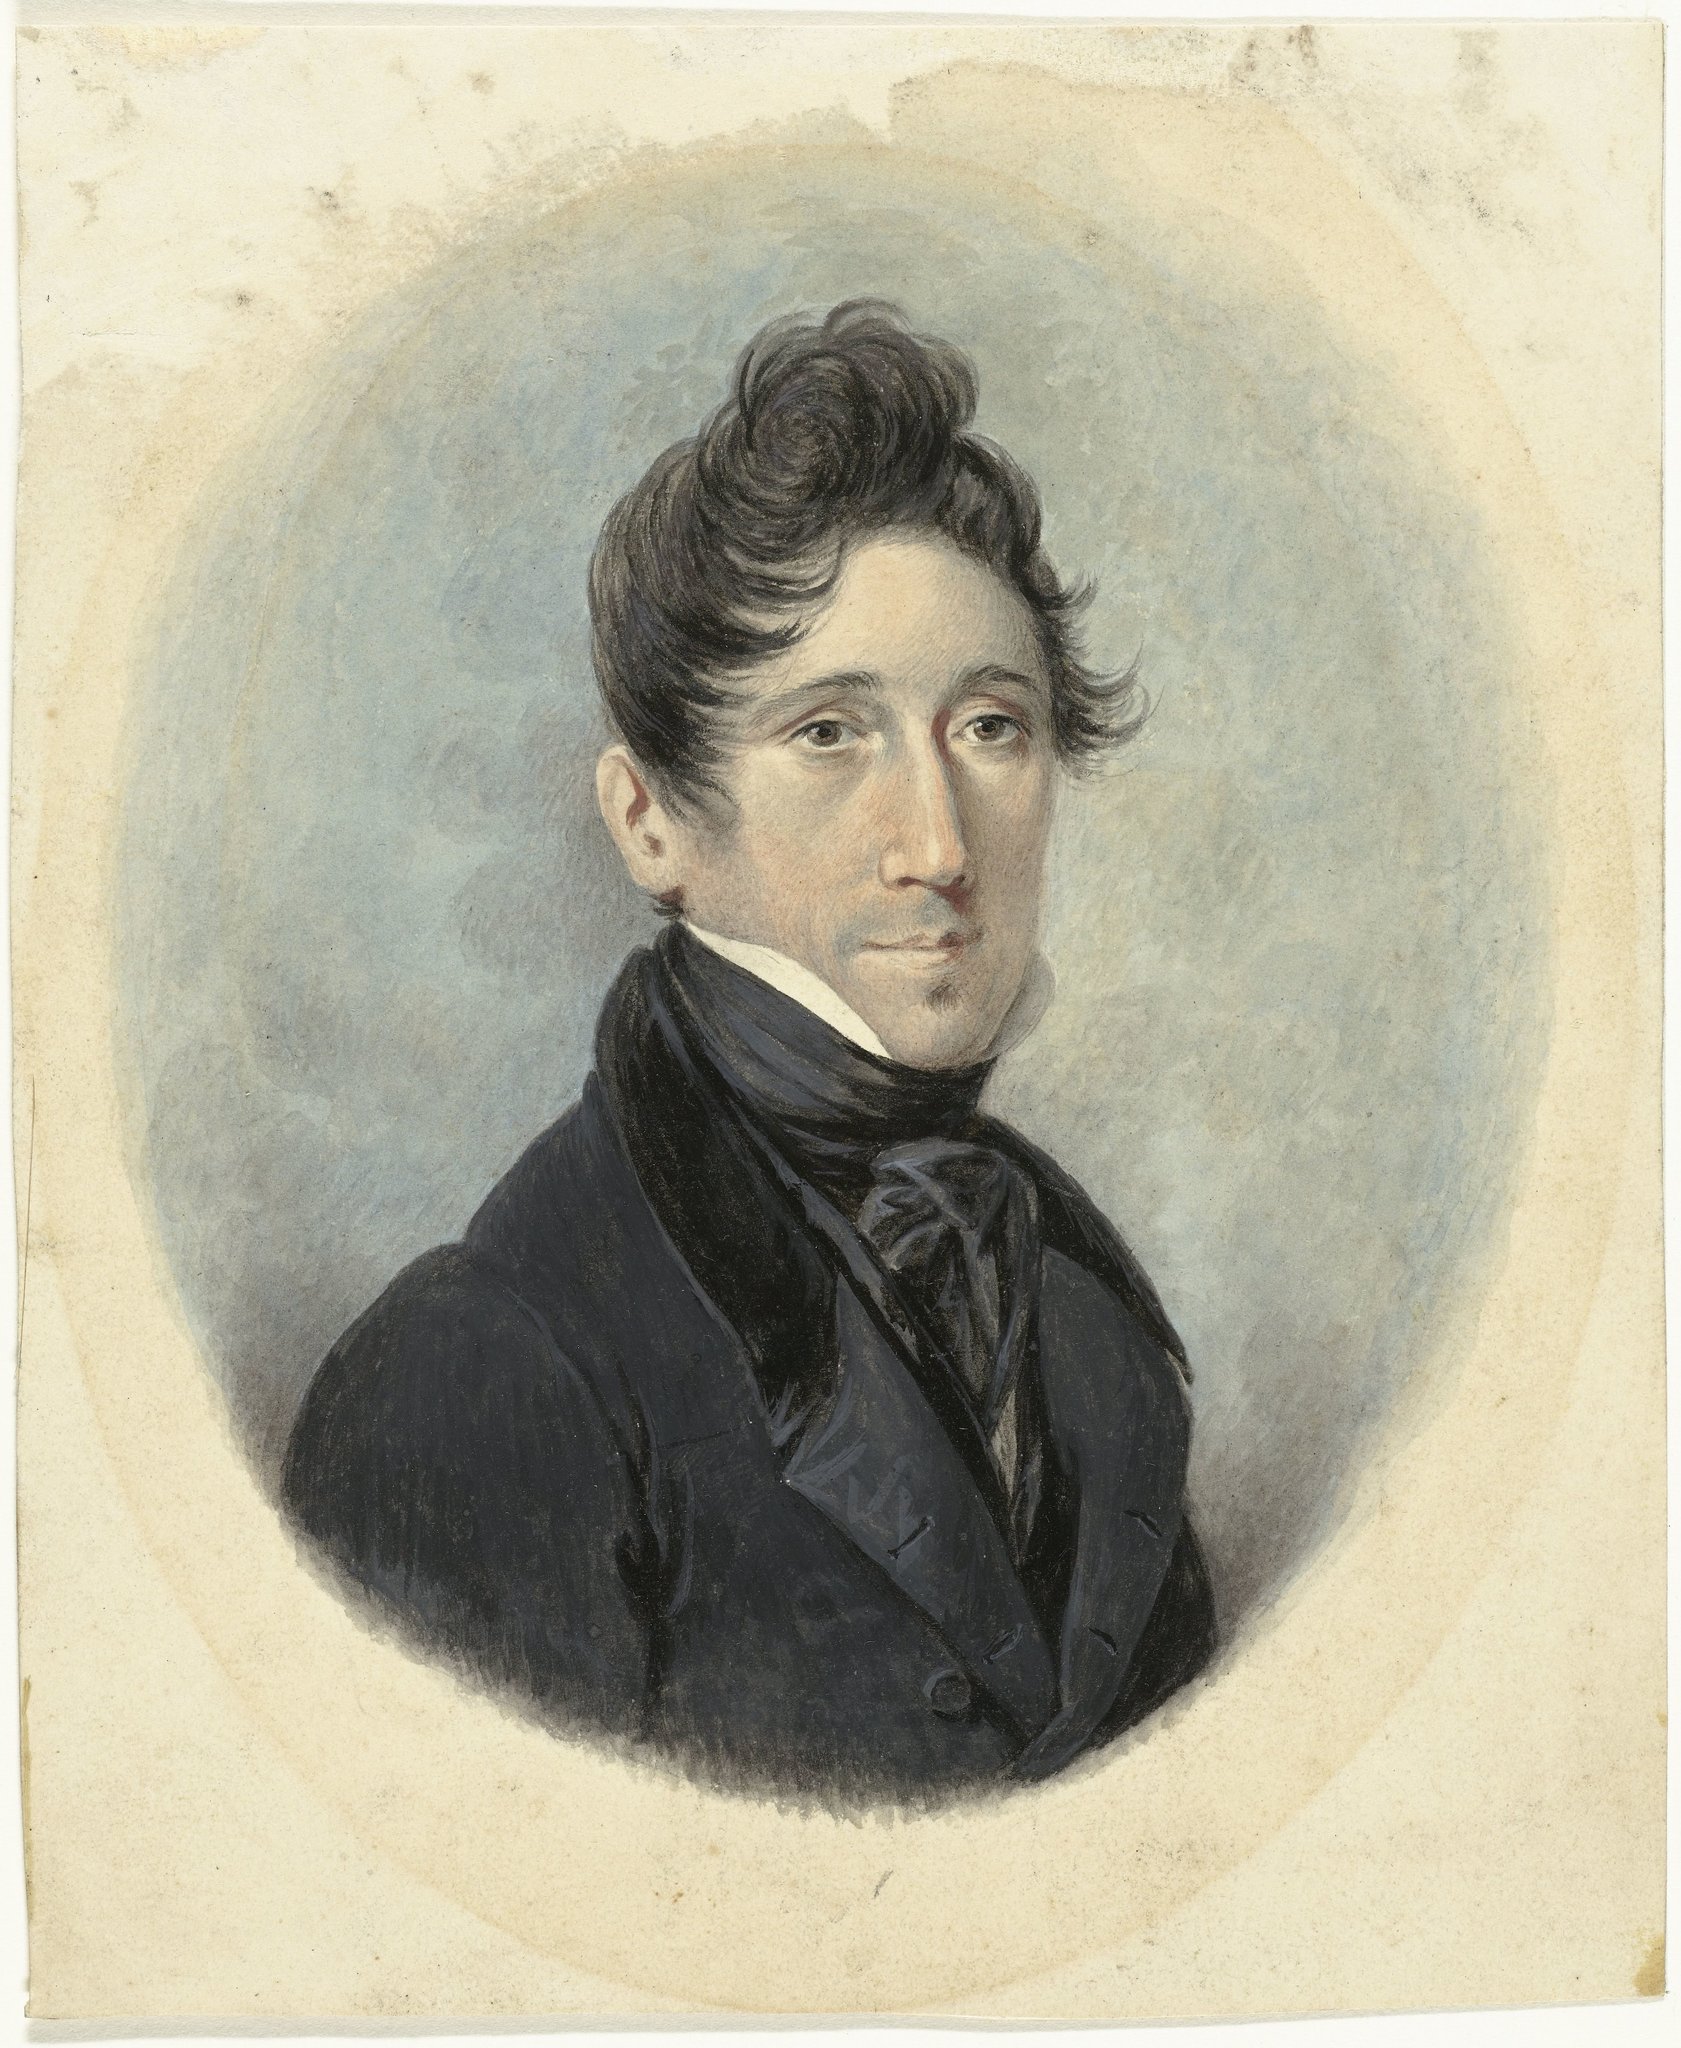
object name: watercolor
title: Zelfportret van Johannes Hari I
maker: johannes hari (i)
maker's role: draughtsman, painter, print maker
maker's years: 1772-1849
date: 1782-1849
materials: paper, pencil, watercolor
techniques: brush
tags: the hague, painter, print maker, draughtsman, johannes hari (i), historical persons, portrait, self-portrait of artist, portrait, self-portrait of draughtsman